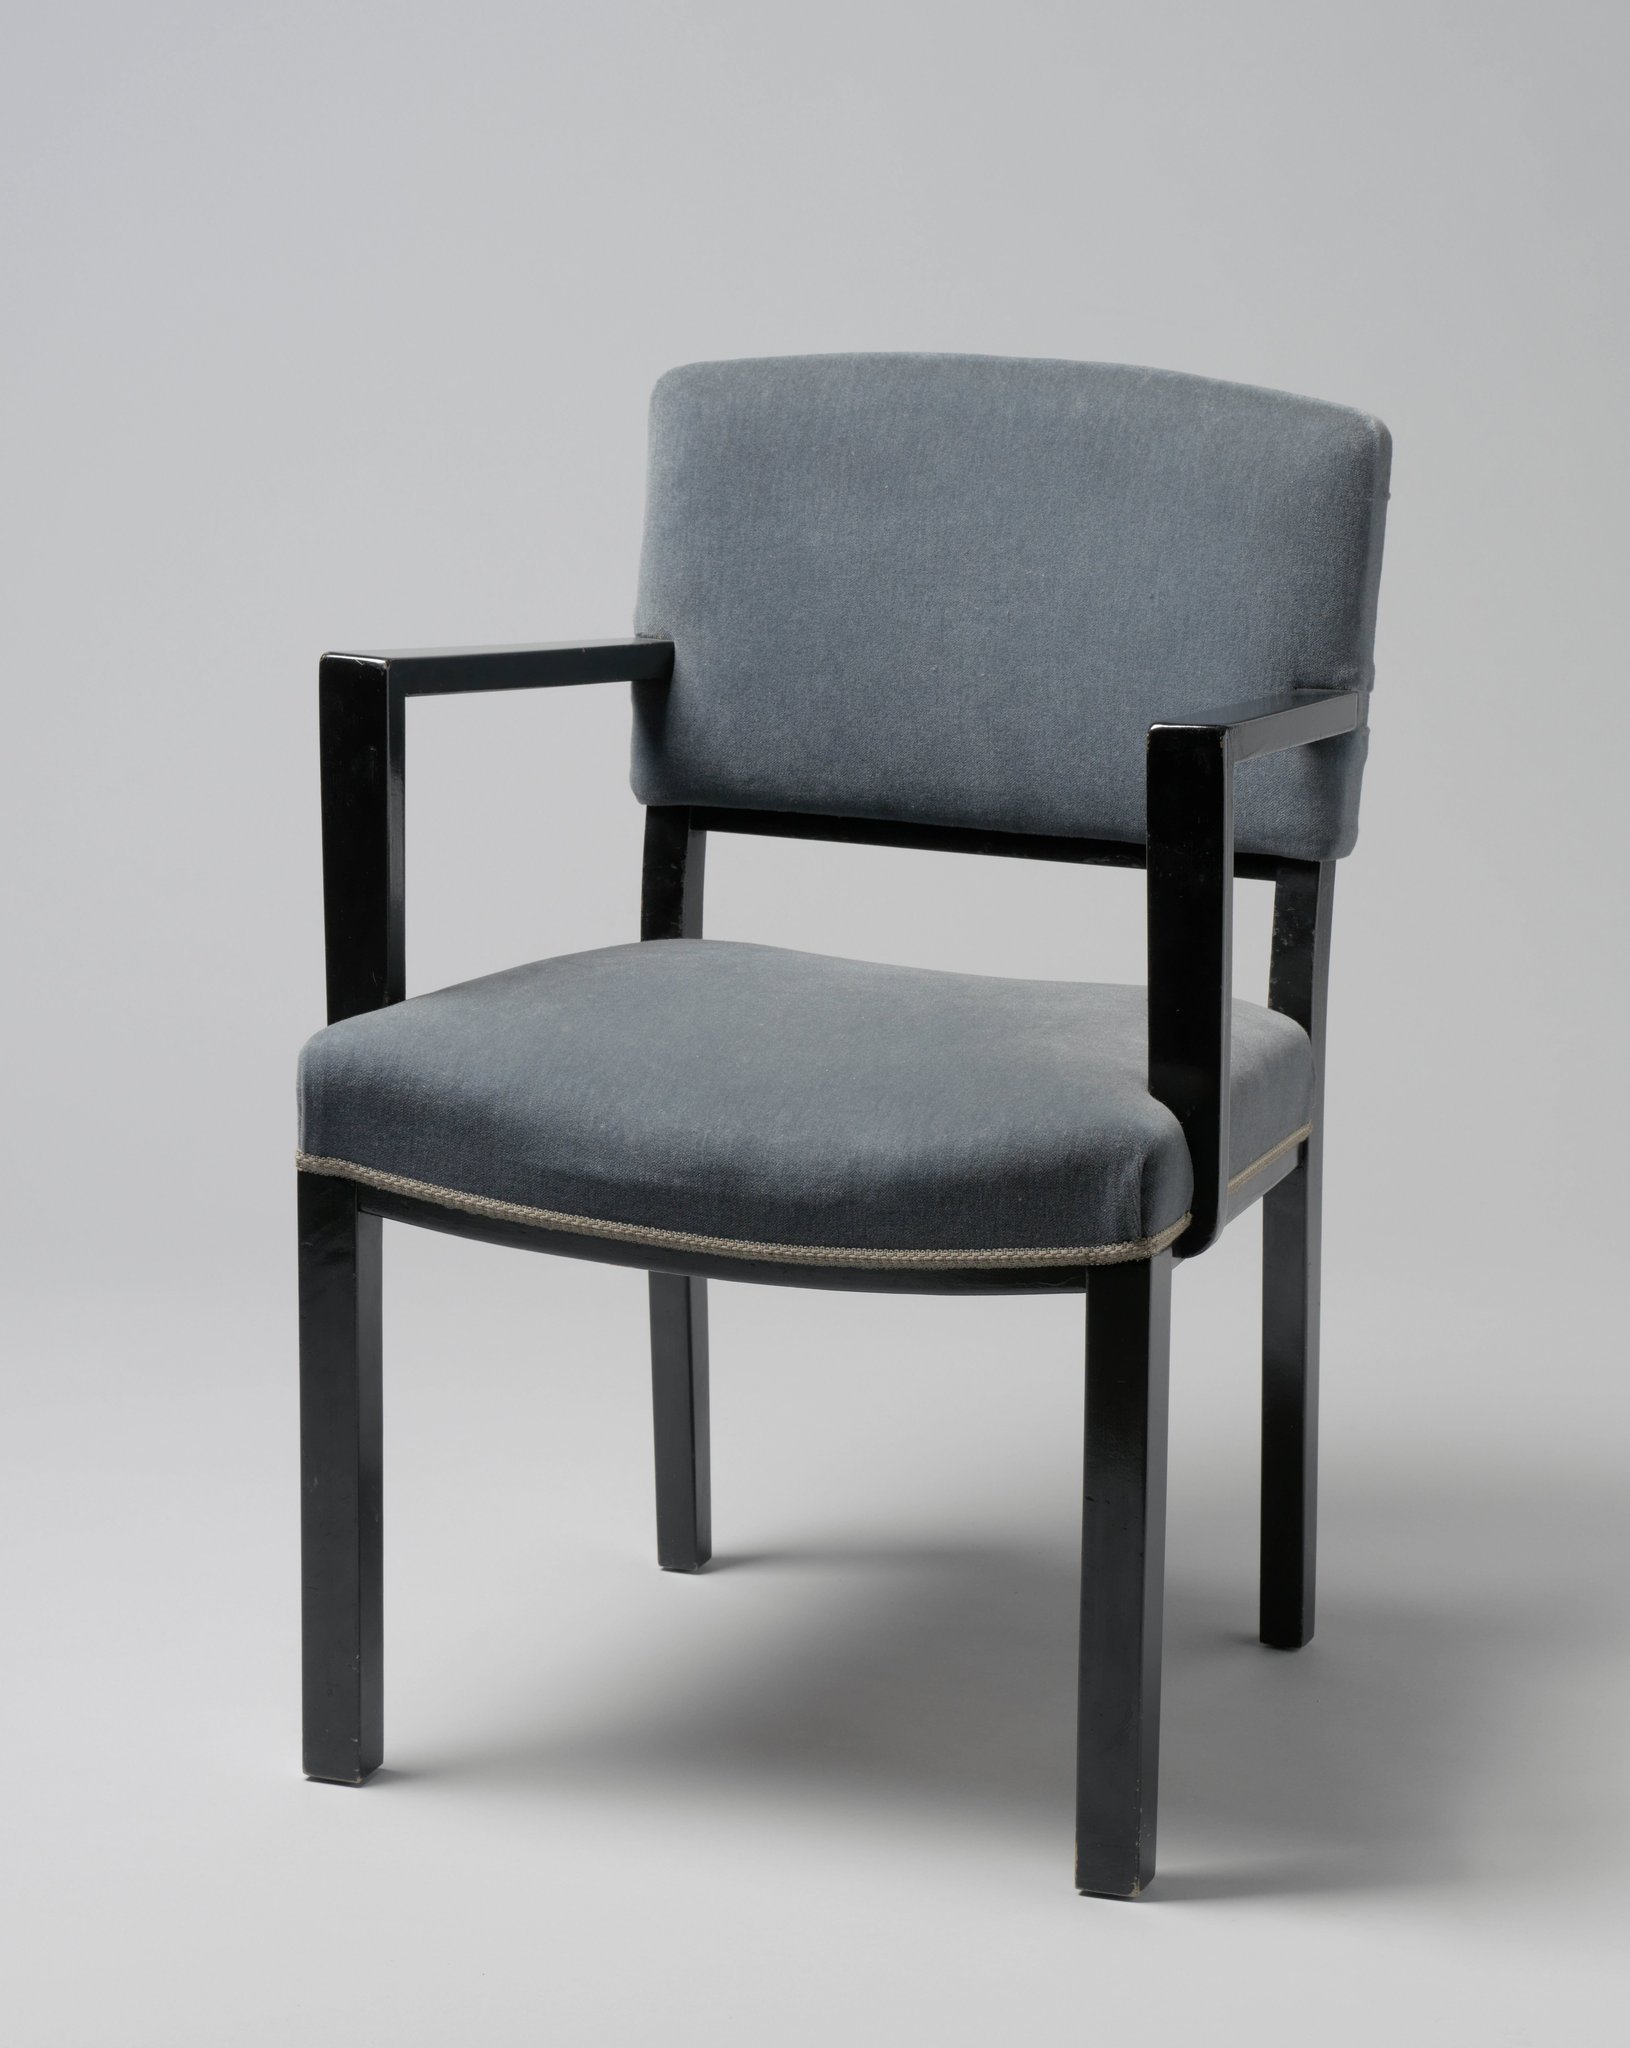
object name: armchair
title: Armstoel met hoekige armleggers en bekleed met blauwe trijp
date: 1933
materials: textile, paint, wood, wool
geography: the hague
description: Armstoel van zwart gelakt hout rustend op vier vierkante poten. De voorpoten zijn recht en de achterpoten zijn licht gebogen en lopen door in de rugstijlen. De zitting is gevat in vier regels waarvan de twee zijregels recht zijn en de voor- en achterregel gebogen. De onderdorpel van de rugleuning is ook gebogen. Vanaf het midden van de rugleuning lopen platte hoekige armleggers af die aan de voorzijde, niet in het verlengde van de voorpoten, rusten op platte stutten die deels op en deels tegen de zitting zijn bevestigd. Zowel de leuning als de zitting is bekleed met blauwe trijp. De bekleding van de zitting is afgezet met een beige bies.